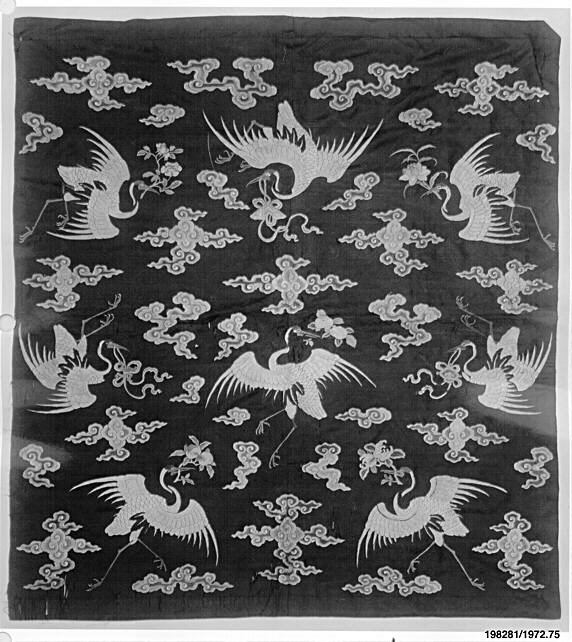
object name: piece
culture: chinese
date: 1662-1722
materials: silk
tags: birds,flowers